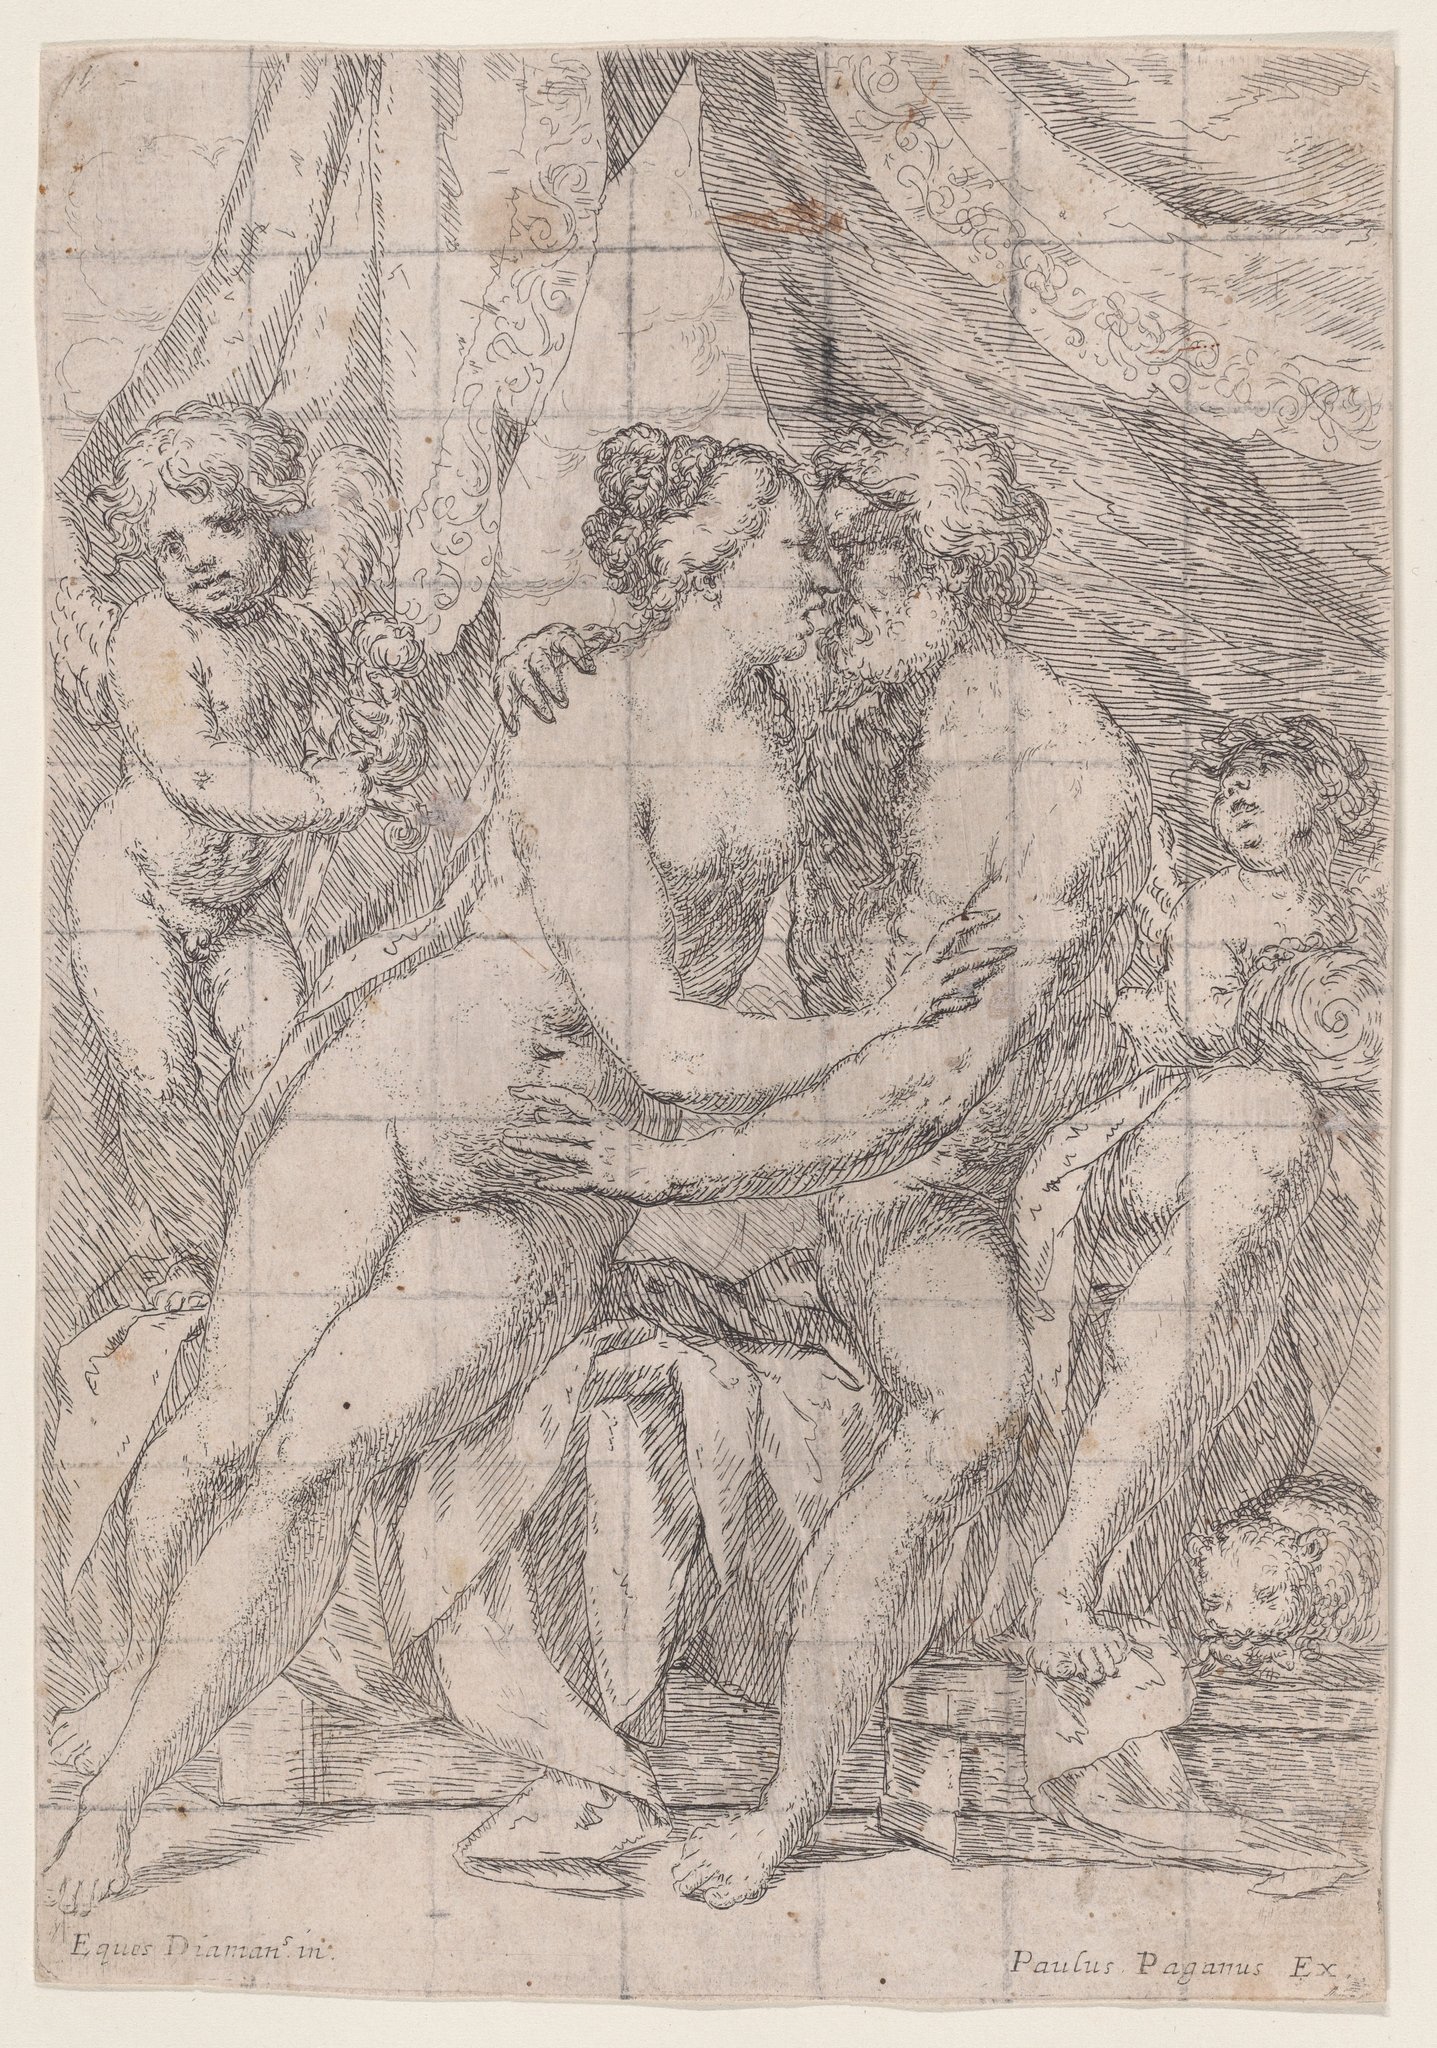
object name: print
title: Venus and Mars embracing with a putto to either side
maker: giuseppe diamantini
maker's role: artist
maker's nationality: italian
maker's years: 1621-1705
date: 1680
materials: chalk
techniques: etching, drawing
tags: female nudes,putti,mars,venus